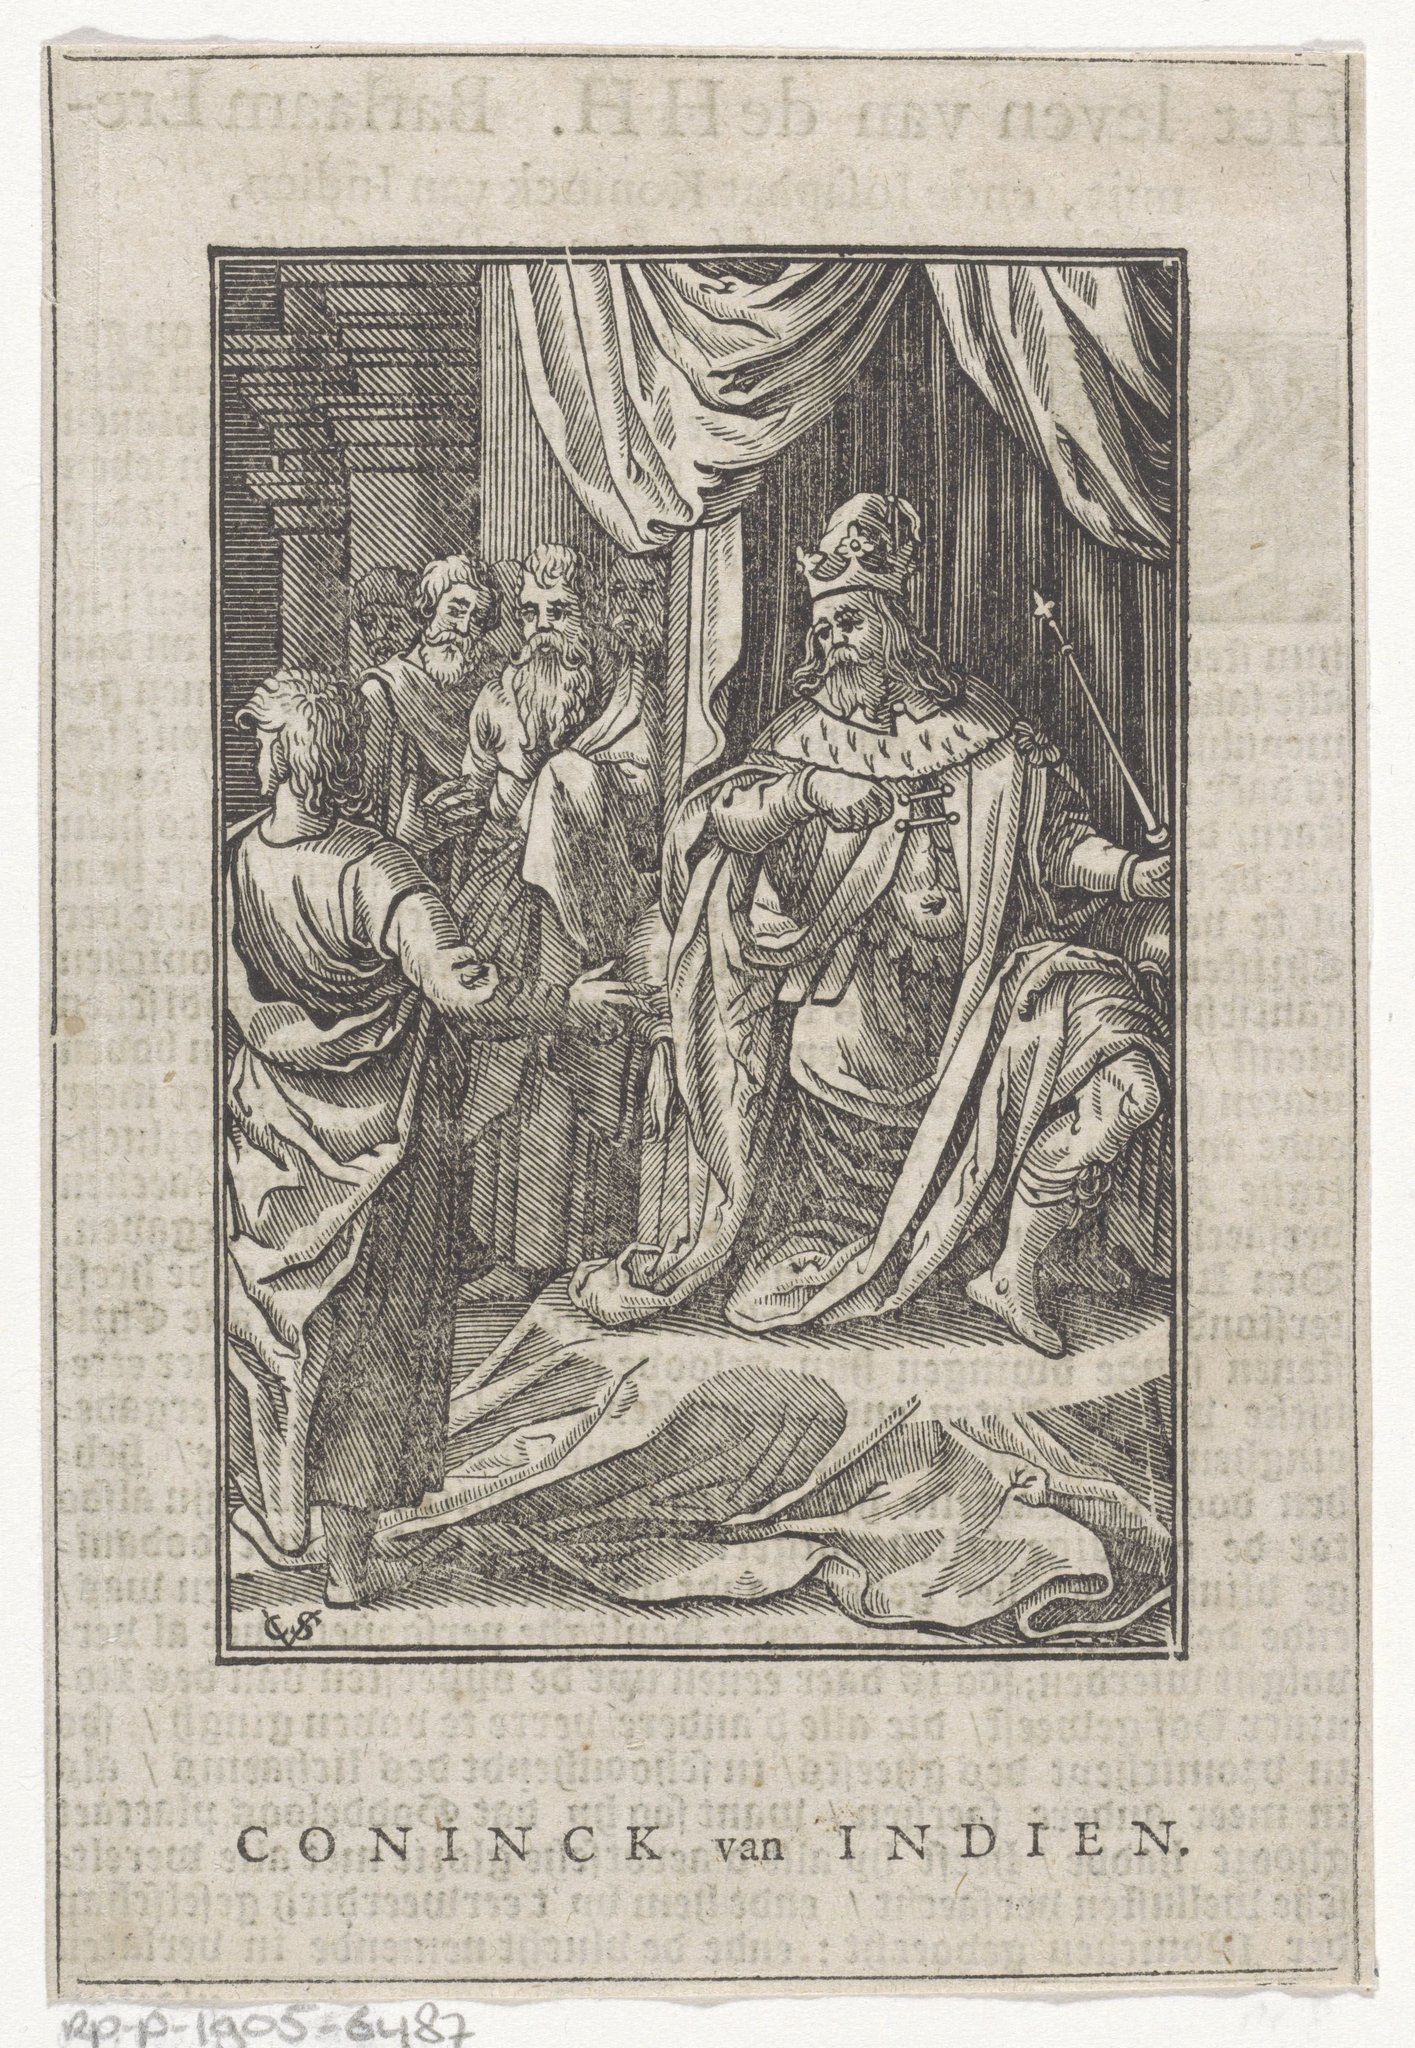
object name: book illustration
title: Koning van Indië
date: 1644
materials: paper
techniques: letterpress printing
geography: amsterdam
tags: king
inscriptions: collector's mark: Lugt 2228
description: Prent uit: Rosweyde, Heribert. 'tBosch der eremyten ende eremitinnen, van Aegypten ende Palestinen. Amsterdam: Pieter Jacobsz. Paets, 1644.